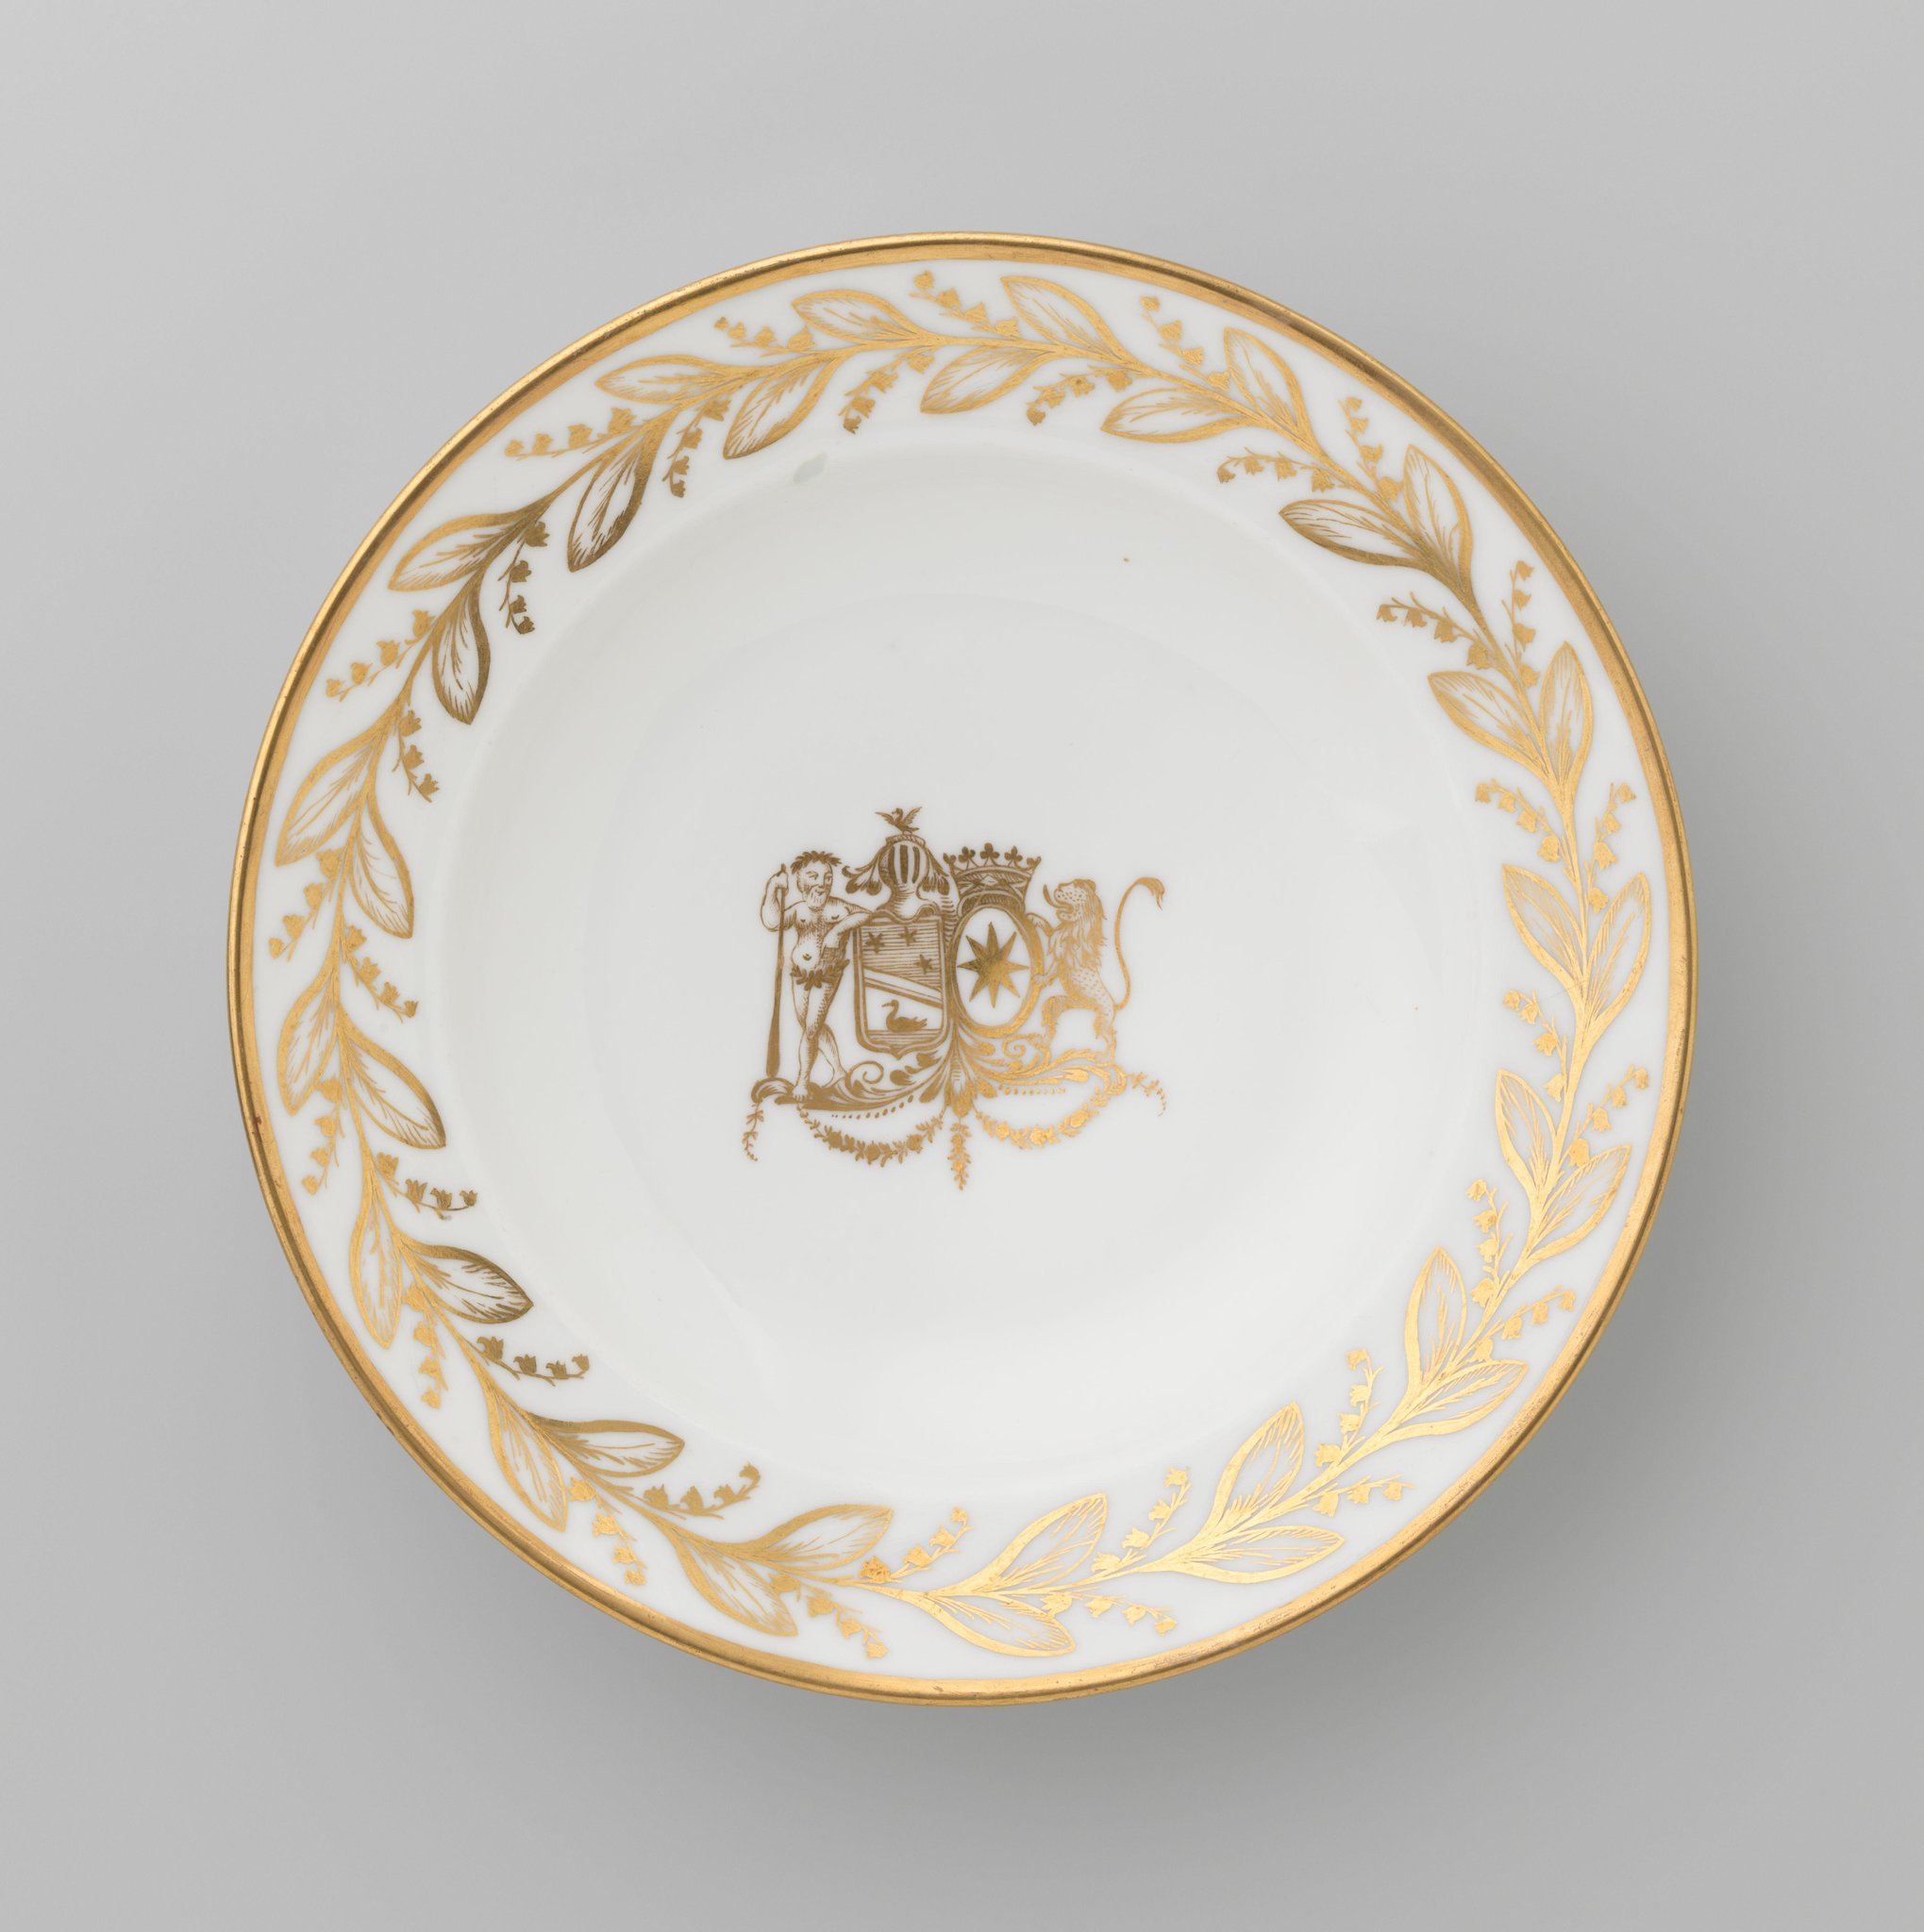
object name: service set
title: Plate with the coat of arms of Hendrik Peter Godfried Quack and Isabella Gertraud von Carnap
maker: Anonymous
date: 1790-1800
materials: glaze, gold, paint, porcelain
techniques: firing, forming, gilding, turning, vitrification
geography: paris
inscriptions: mark: ‘N’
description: Diep bord van porselein, beschilderd op het glazuur met goud. Op het plat het alliantiewapen van Hendrik Peter Godfried Quack en Isabella Gertraud von Carnap. De rand met een bloemrank en een gouden band. Twee proenen op de onderzijde. Gemerkt op de onderzijde met N.